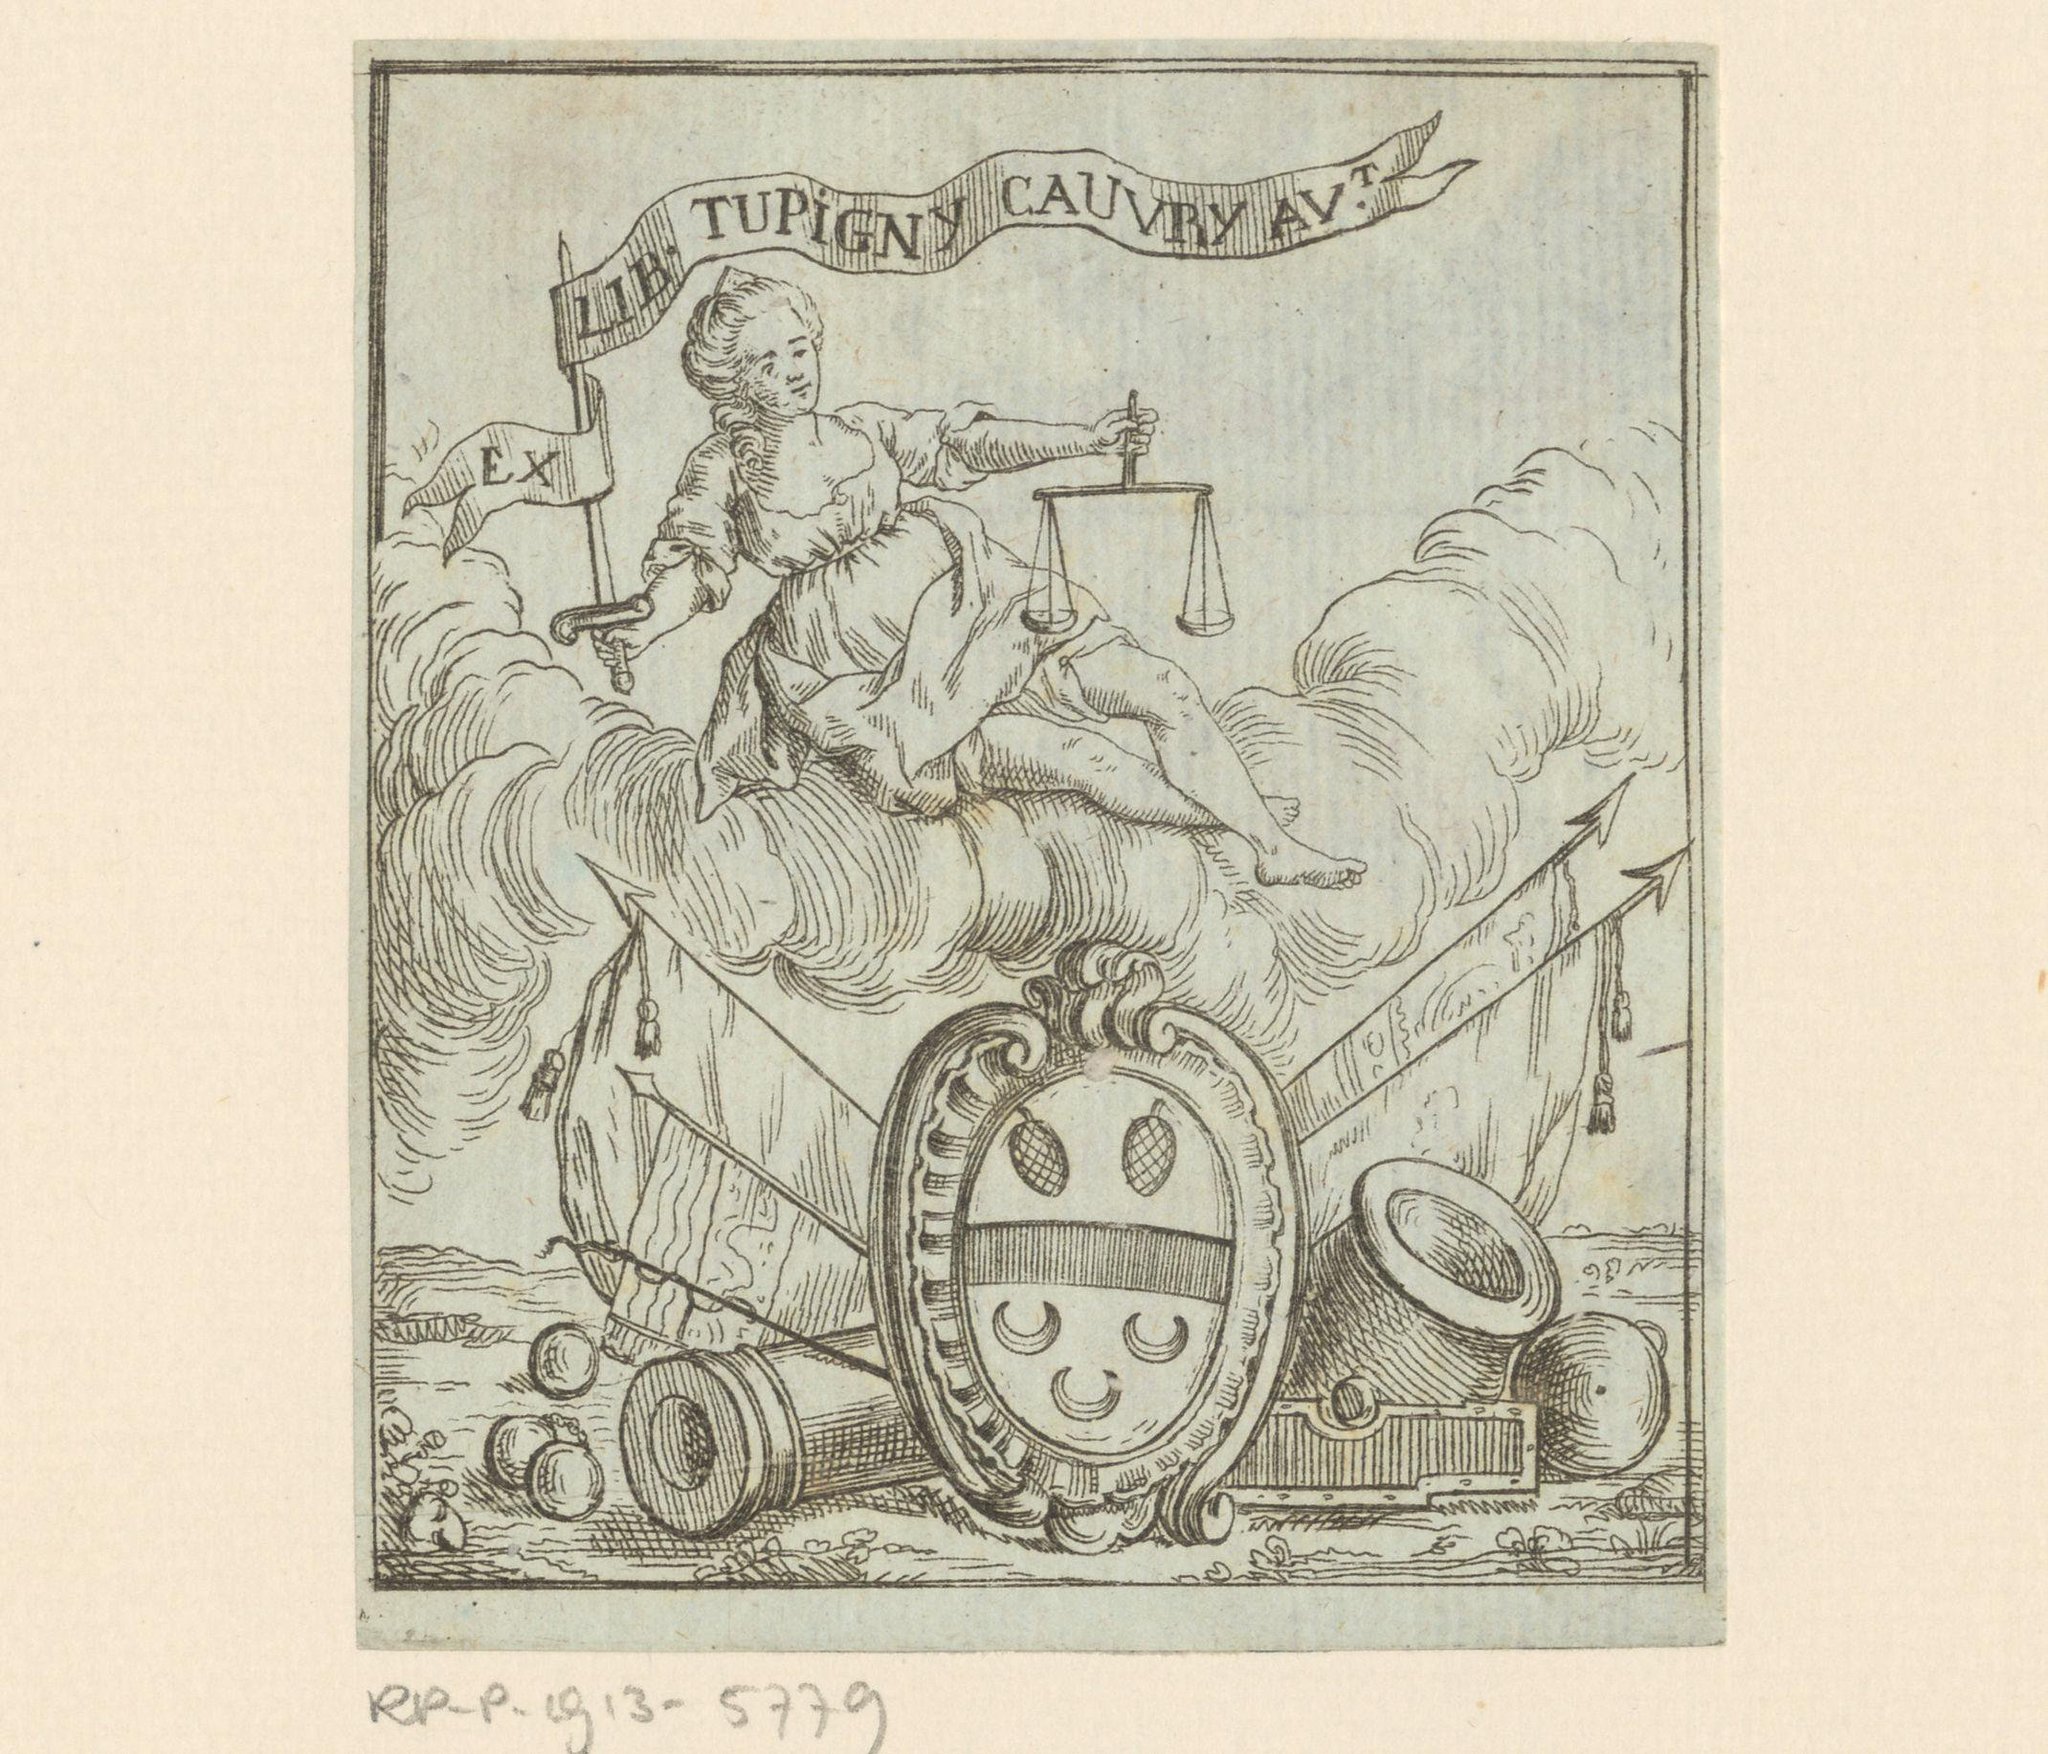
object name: bookplate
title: Ex libris van Pierre-Louis Tupigny de Cauvry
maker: Anonymous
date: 1700-1849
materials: paper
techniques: etching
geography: france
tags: sitting figure - aa - female human figure, justitia (justice) as roman personification, warfare; military affairs, law and jurisprudence, armorial bearing, heraldry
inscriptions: collector's mark: Lugt 2760, collector's mark: Lugt 2233